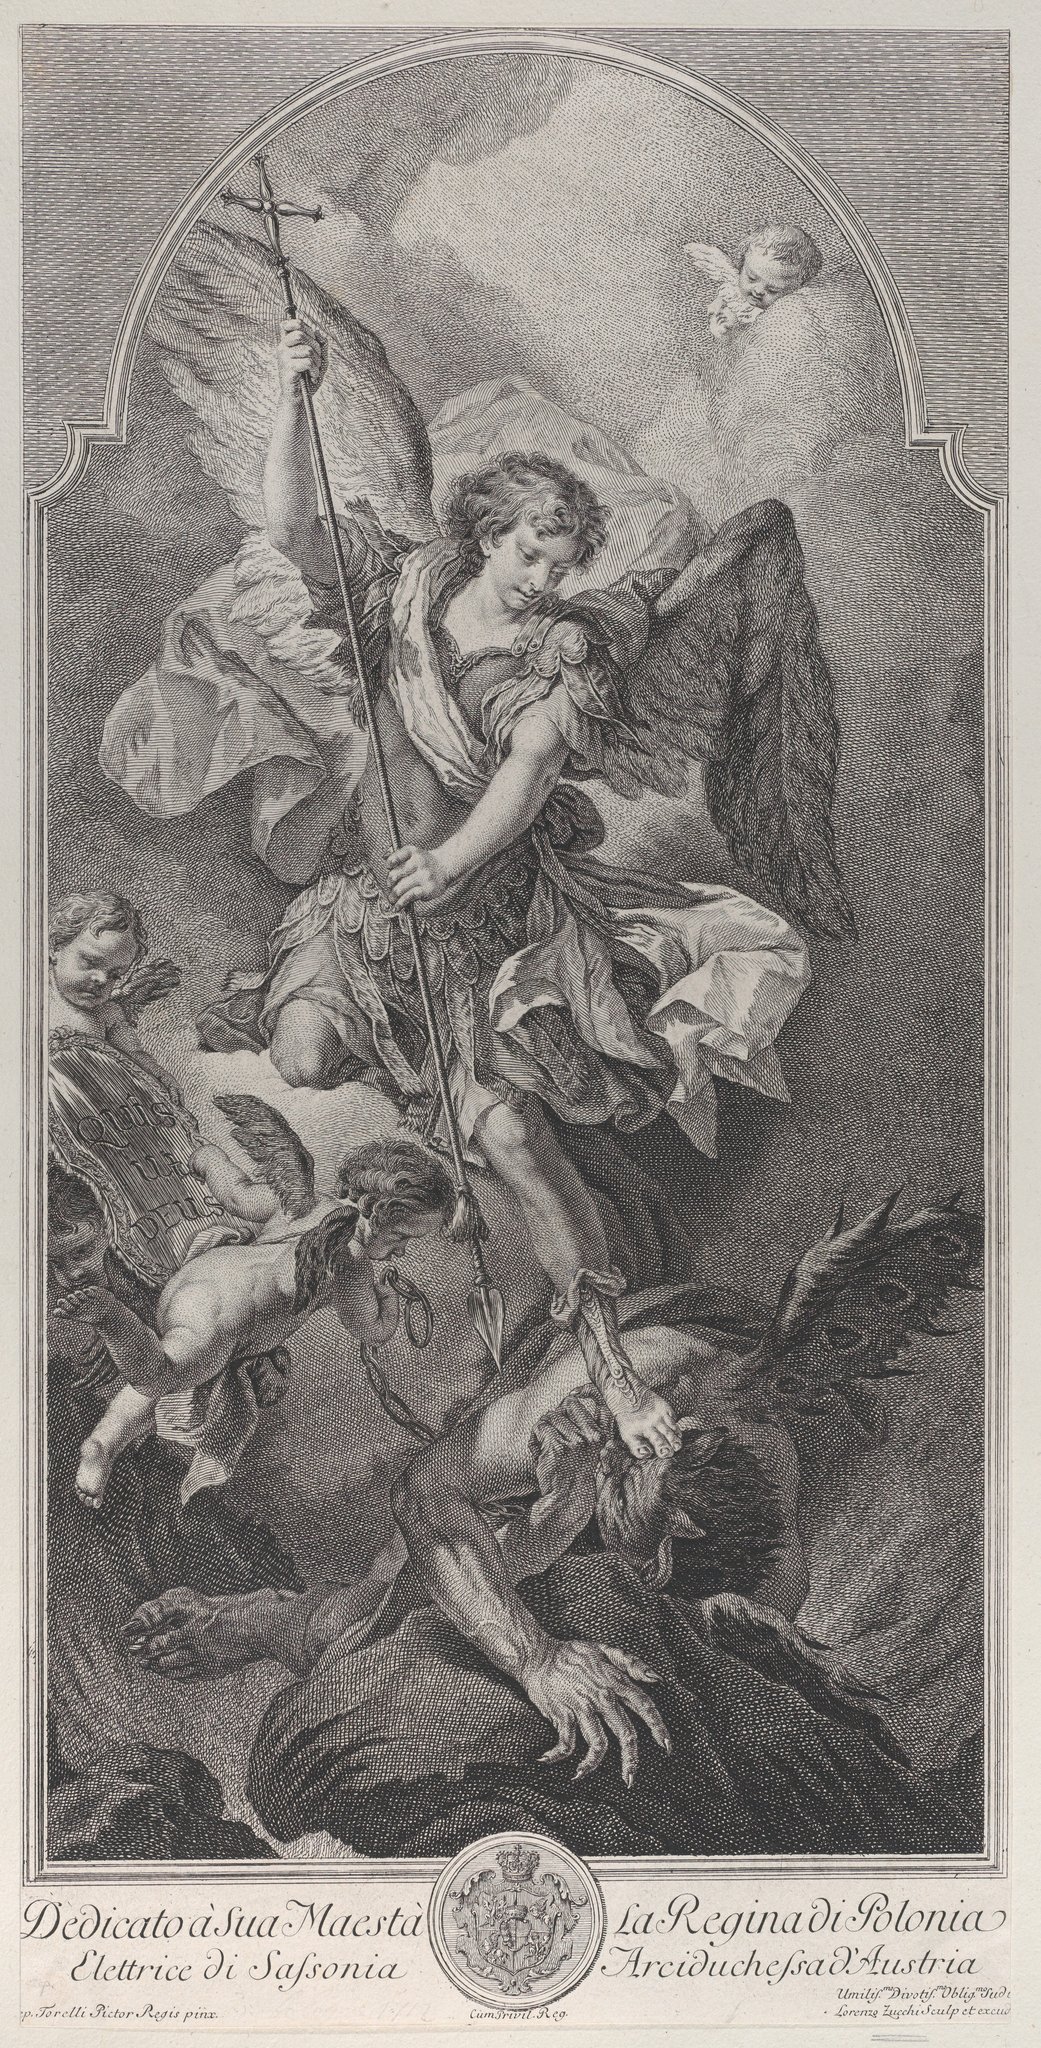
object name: print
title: The Archangel Michael defeats Satan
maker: lorenzo zucchi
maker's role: artist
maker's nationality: italian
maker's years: 1704-1779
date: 1725-1779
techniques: etching